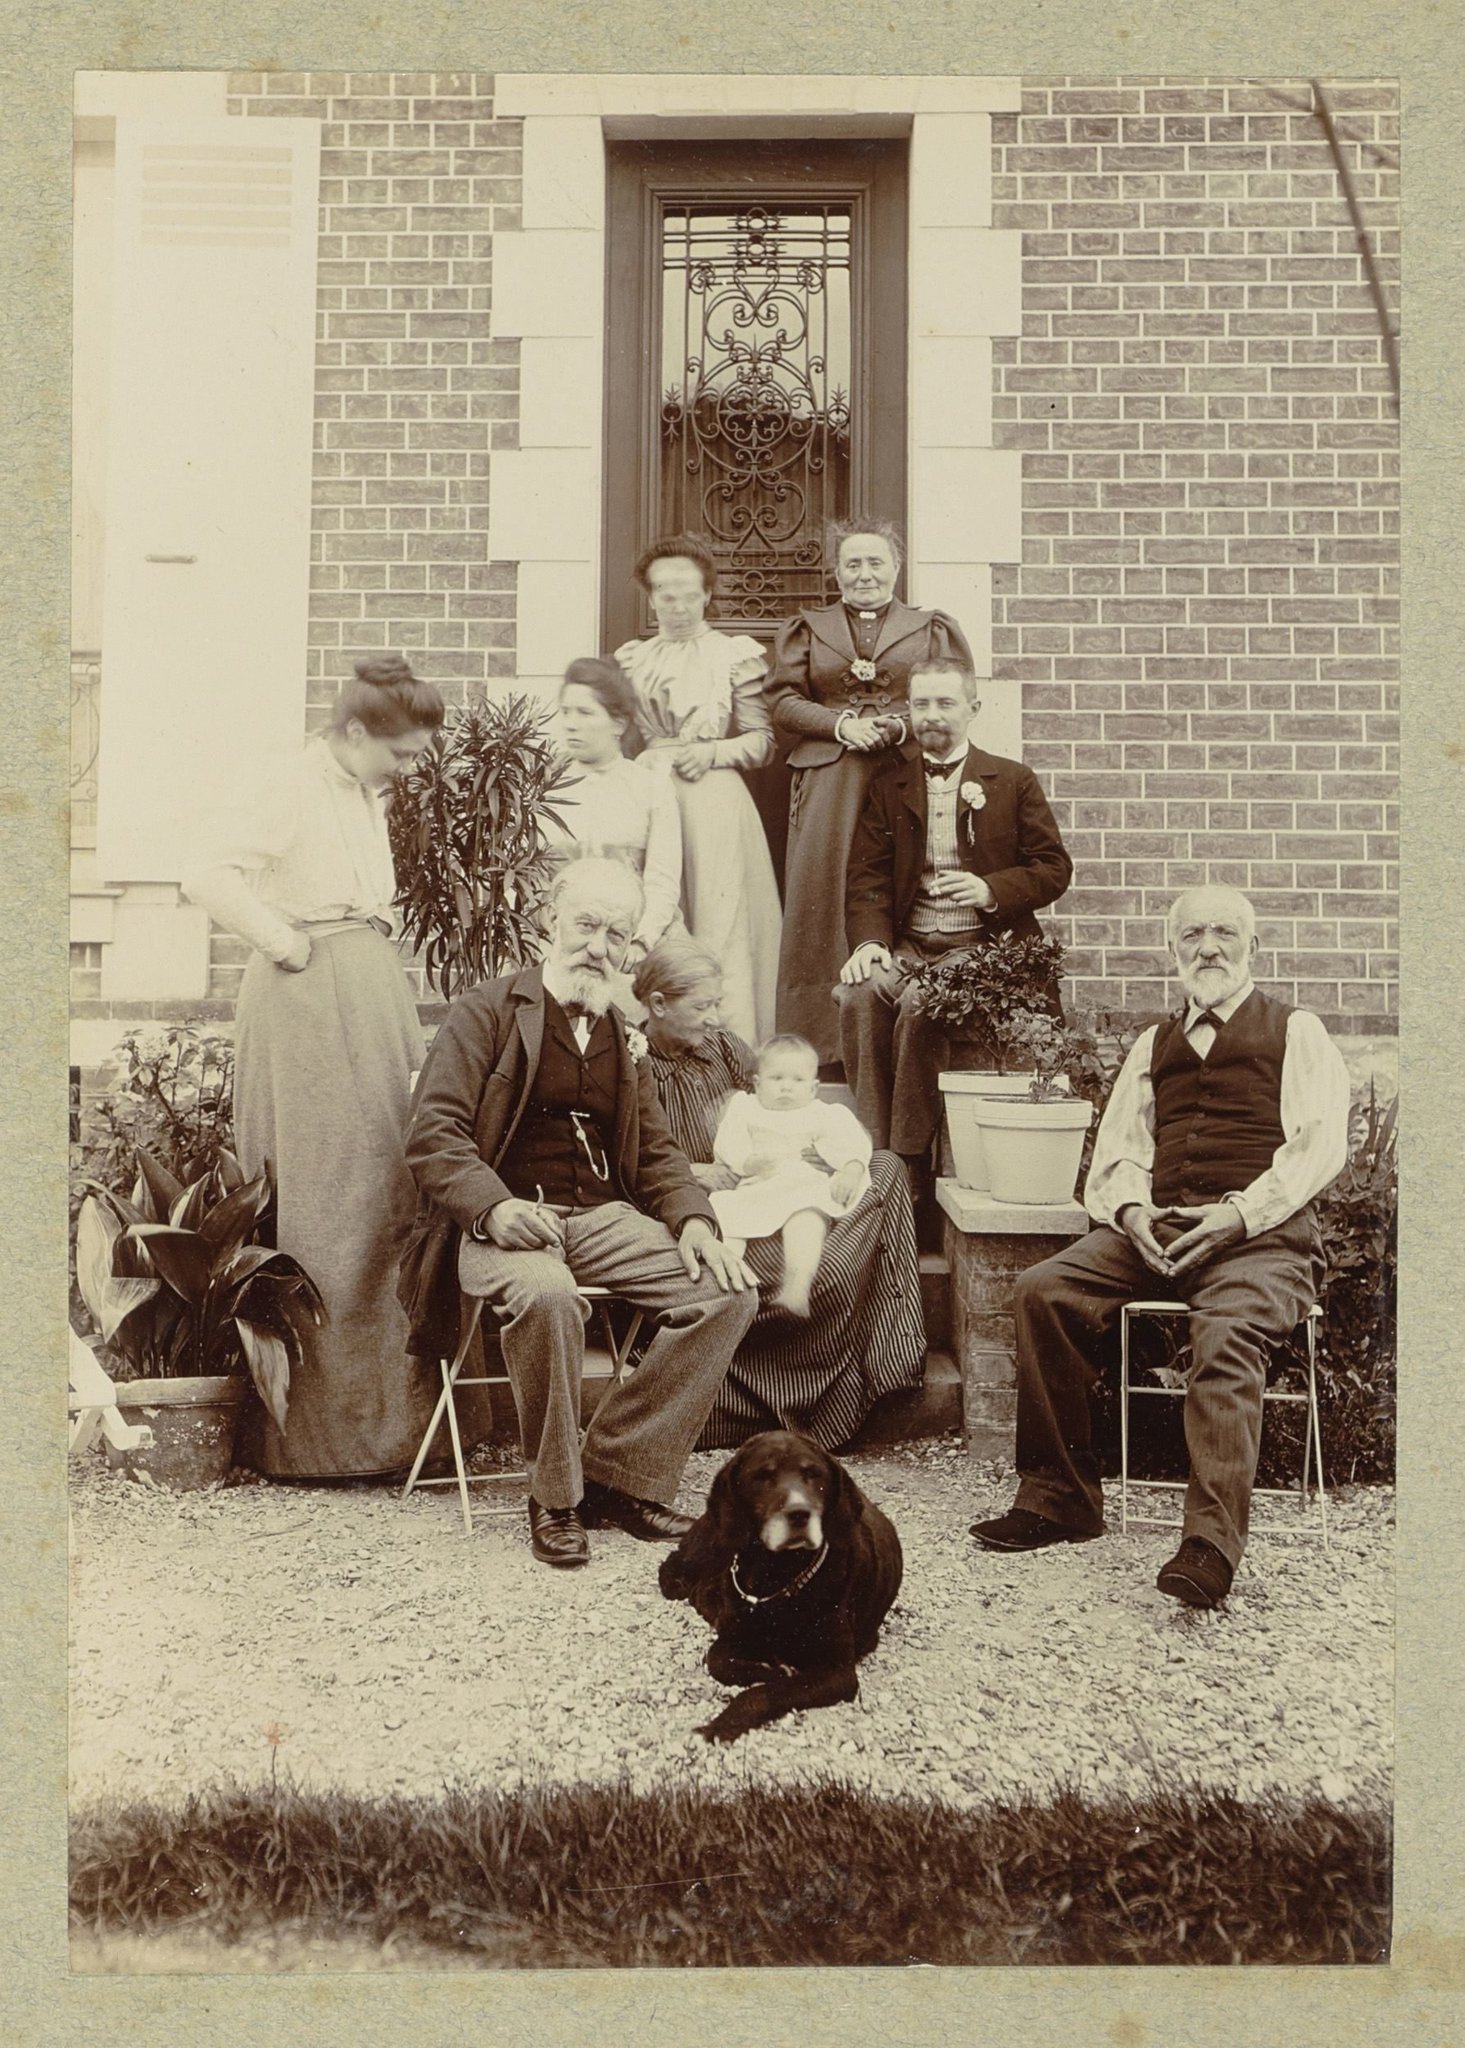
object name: photograph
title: Mannen, vrouwen, een baby en een hond poserend voor een deur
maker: Anonymous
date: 1885-1914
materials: photographic support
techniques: gelatin silver print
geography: france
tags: three generations (family group), dog, france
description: Onderdeel van Fotoalbum met familiefoto's.